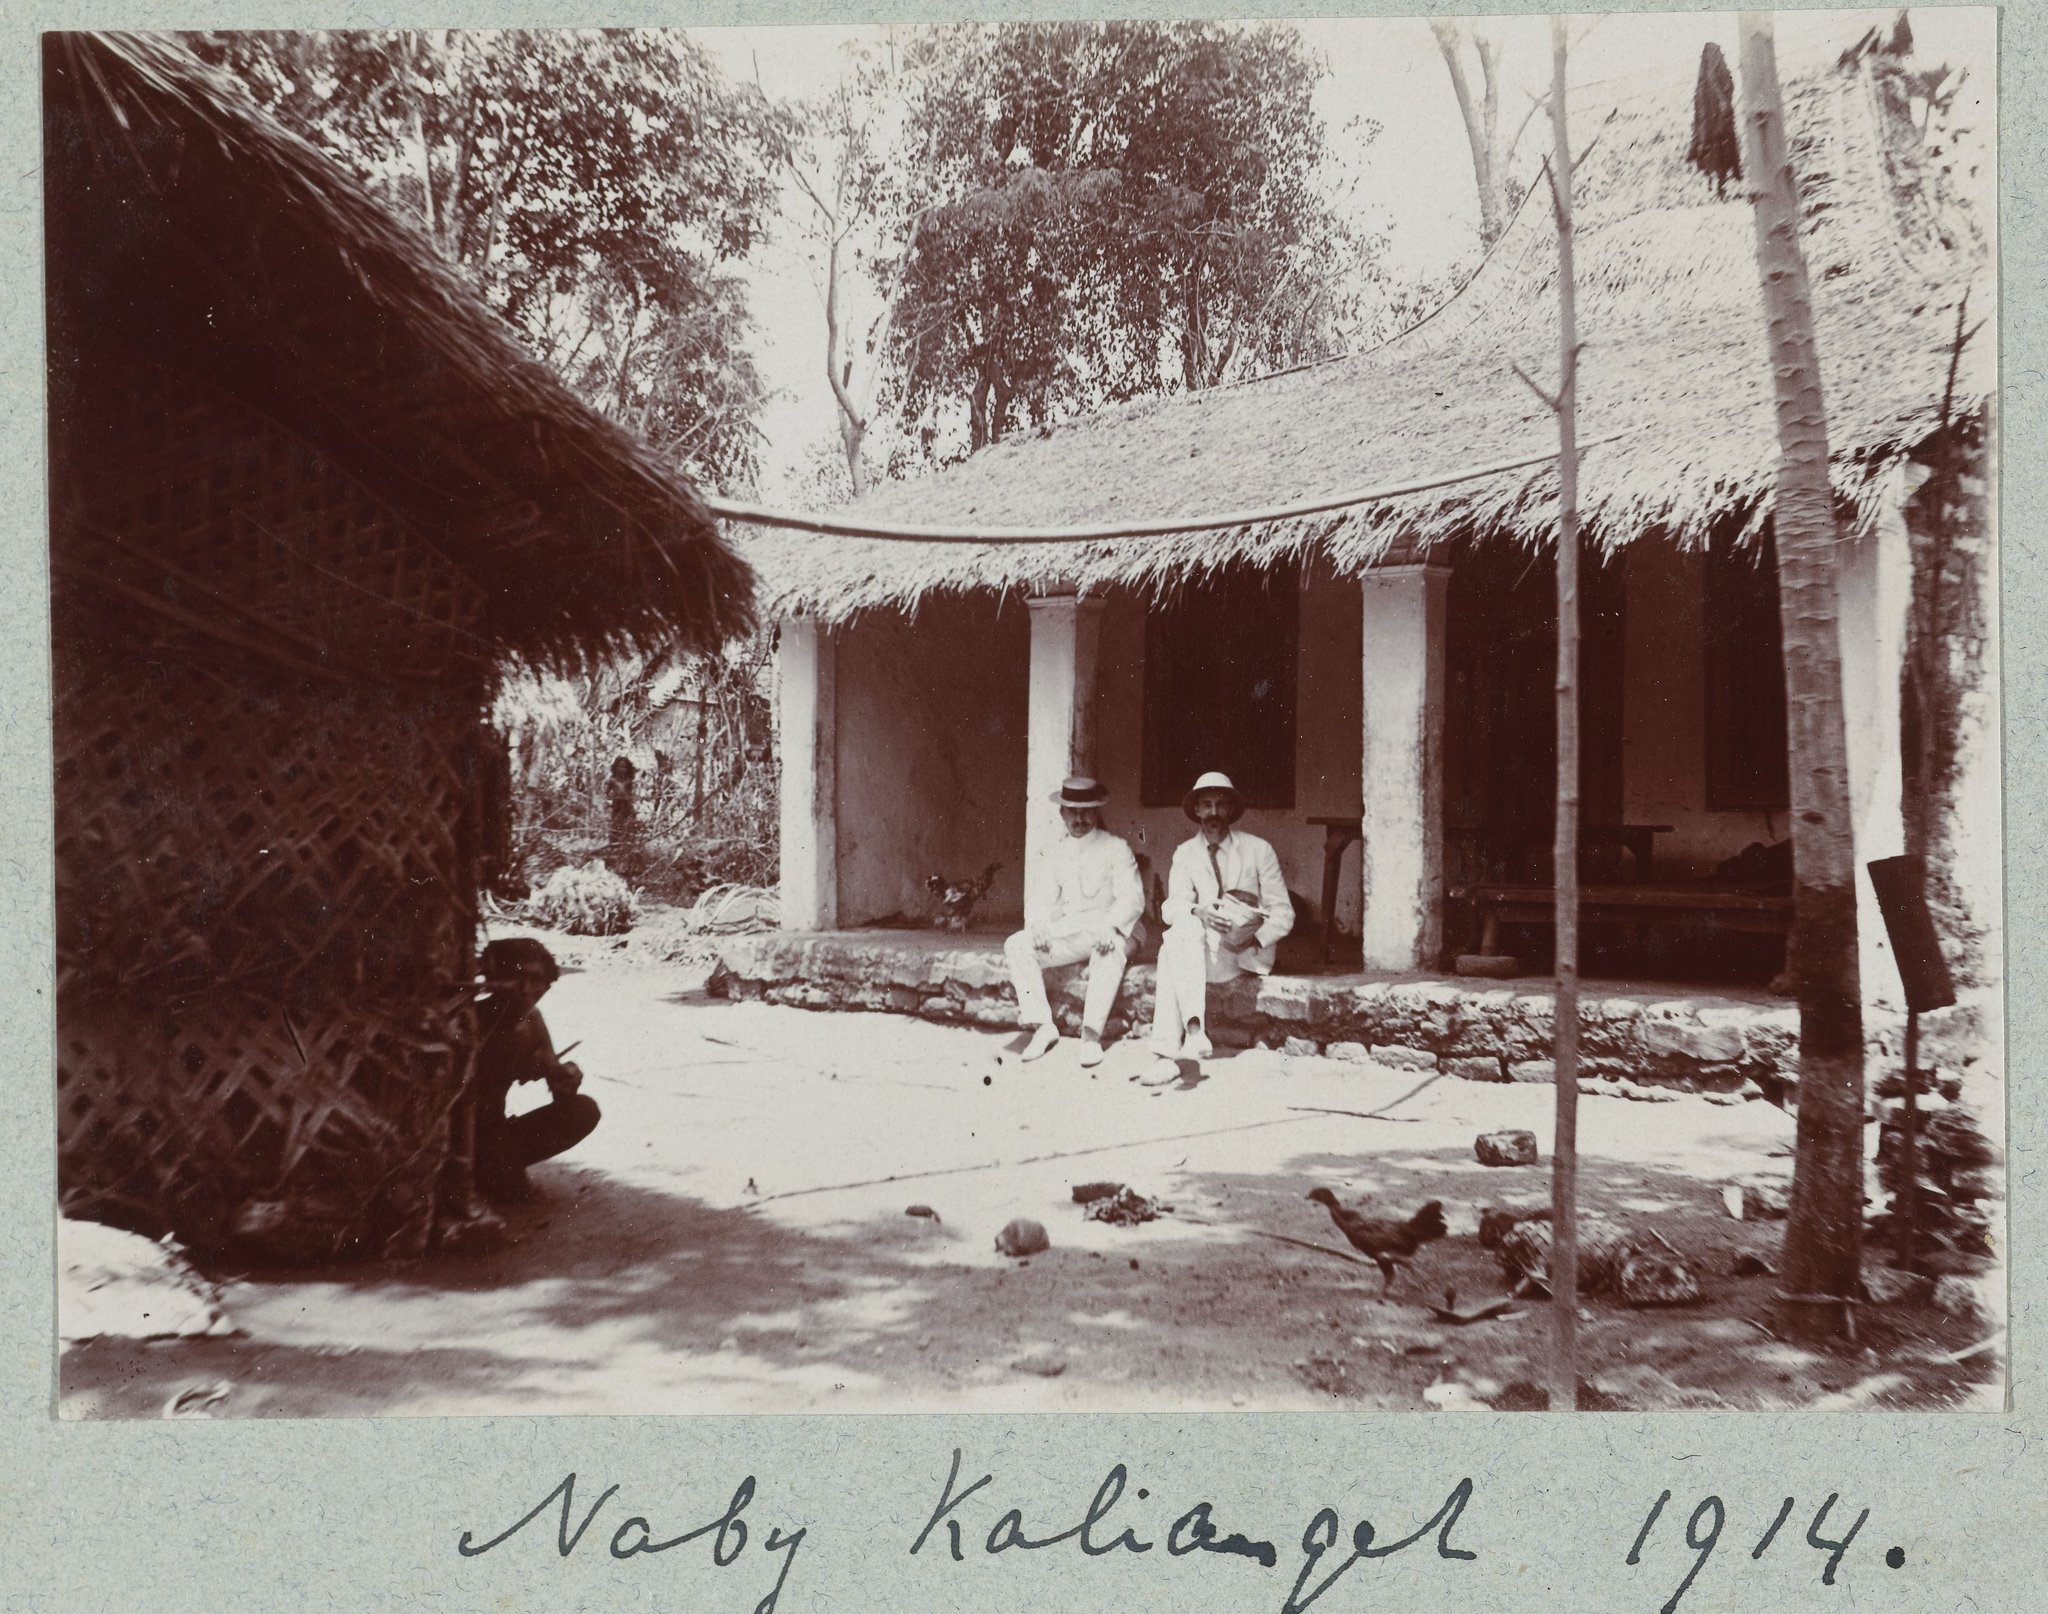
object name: photograph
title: Nabij Kalianget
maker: frits freerks fontein fz.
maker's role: fotograaf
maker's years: 1882-1928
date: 1912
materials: cardboard, paper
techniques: gelatin silver print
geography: madura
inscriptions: caption: ‘Nabij Kalianget’